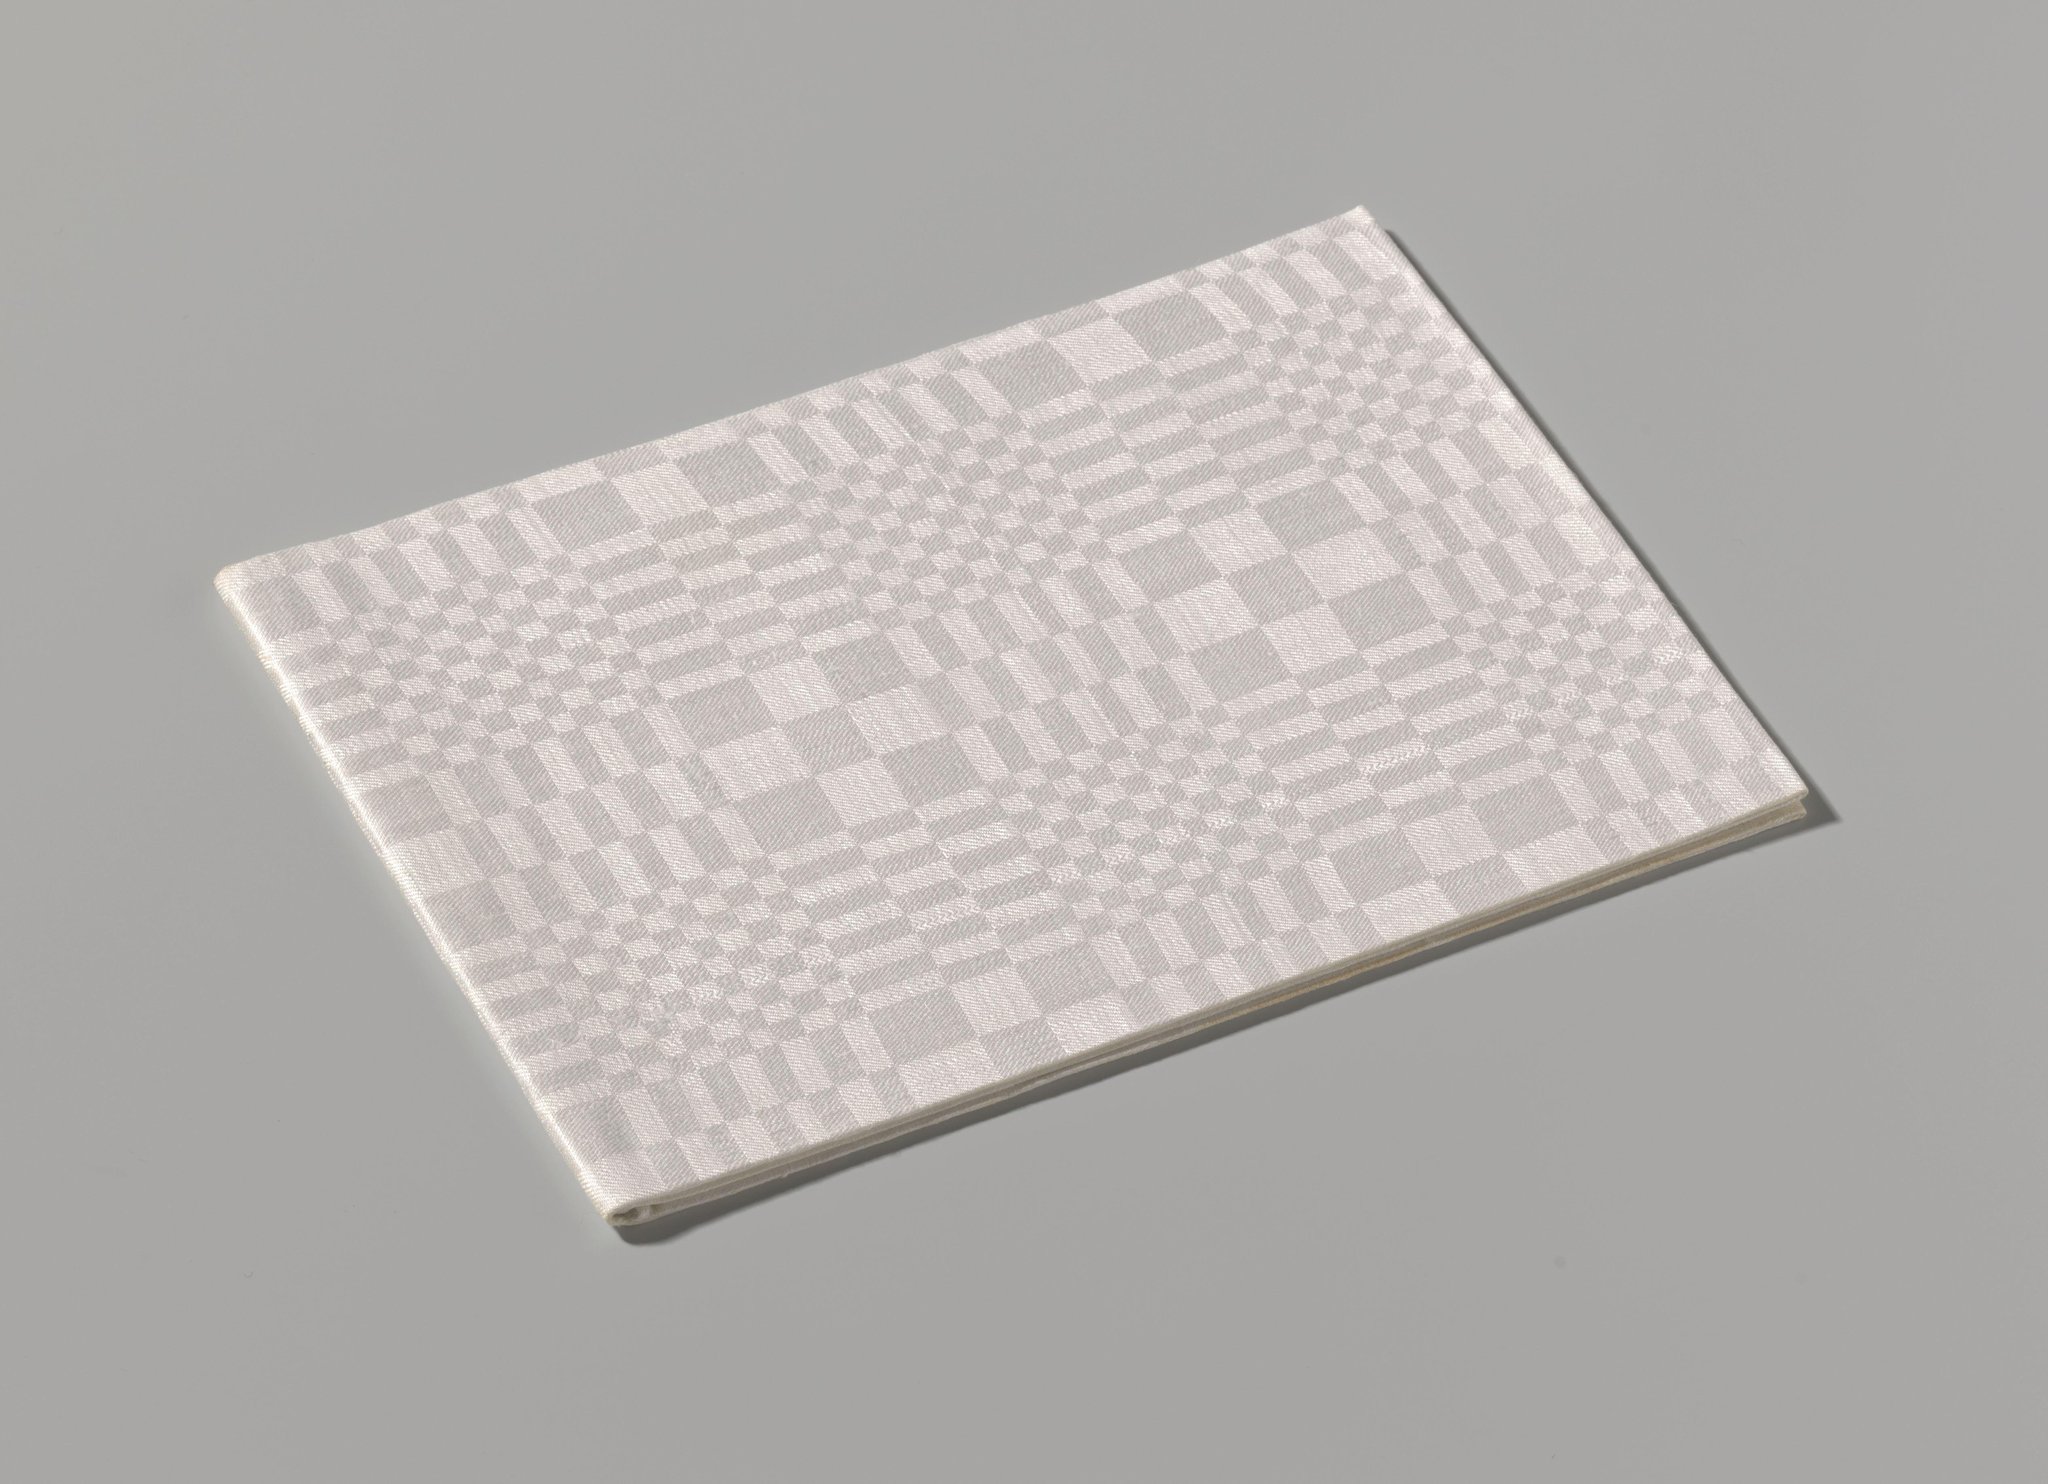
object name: napkin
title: Servet van linnen met pellenpatroon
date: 1784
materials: linen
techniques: twill, peeled fabric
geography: northern netherlands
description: wit linnen servet met pellen patroon, z.g. Engelse garderobe, merk WS 104 en 1784